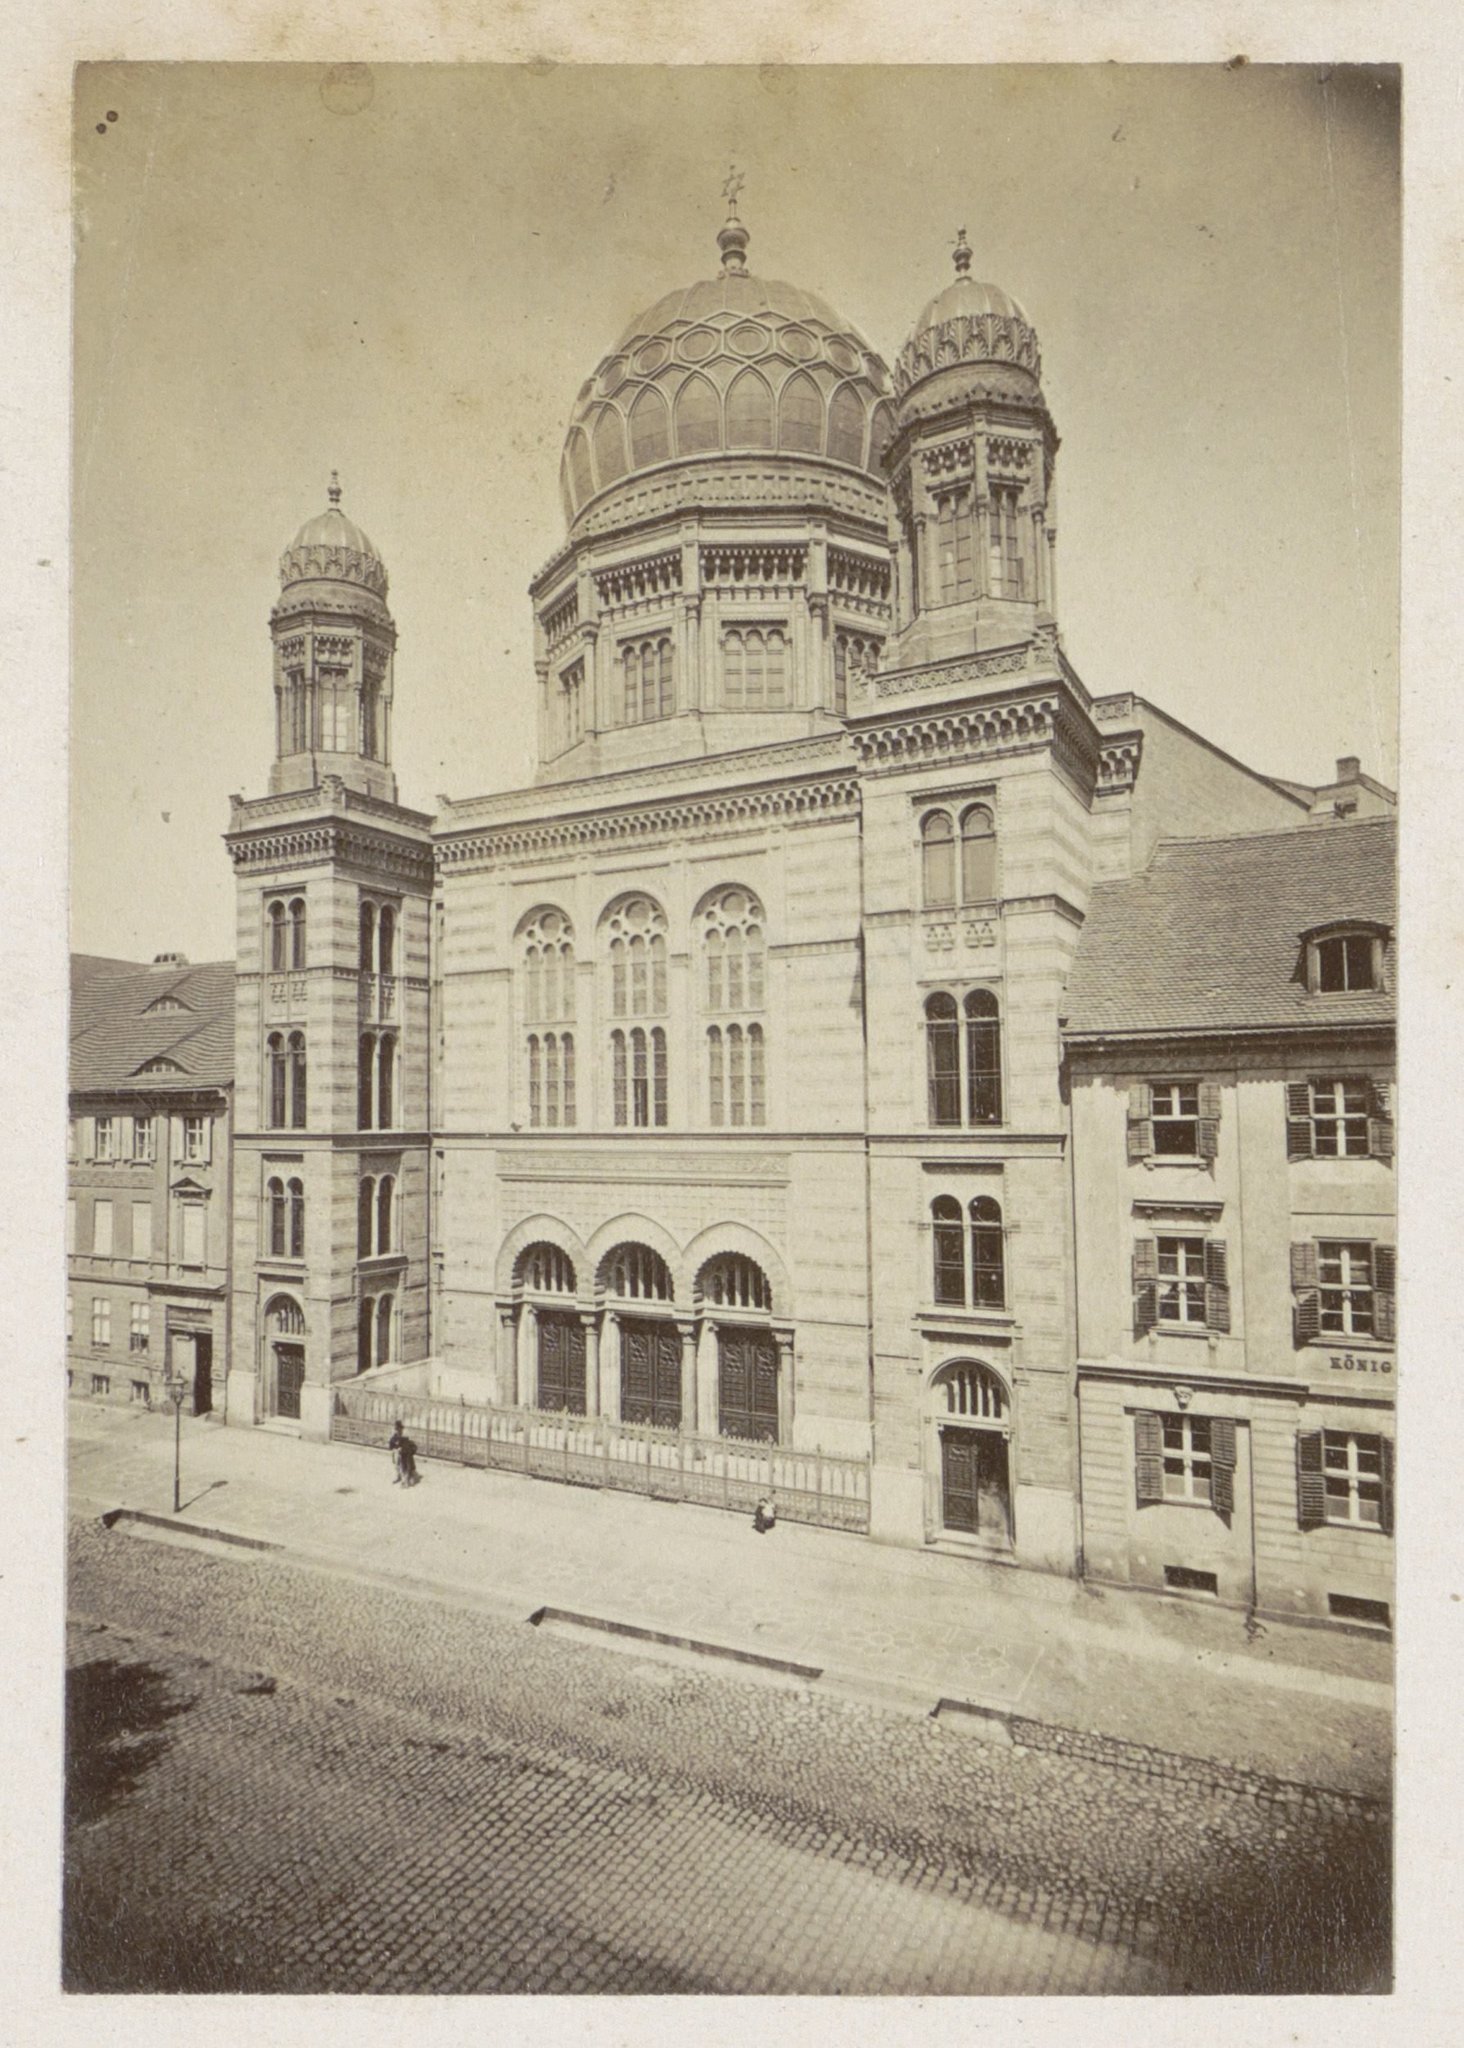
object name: photograph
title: Berliner Synagogan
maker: Anonymous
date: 1878-1890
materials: photographic support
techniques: albumen print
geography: berlin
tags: the synagogue (as building and place of worship ~ jewish religion), façade (of house or building), dome ~ architecture, berlin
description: Onderdeel van Reisalbum Europese steden, vermoedelijk Zweeds.